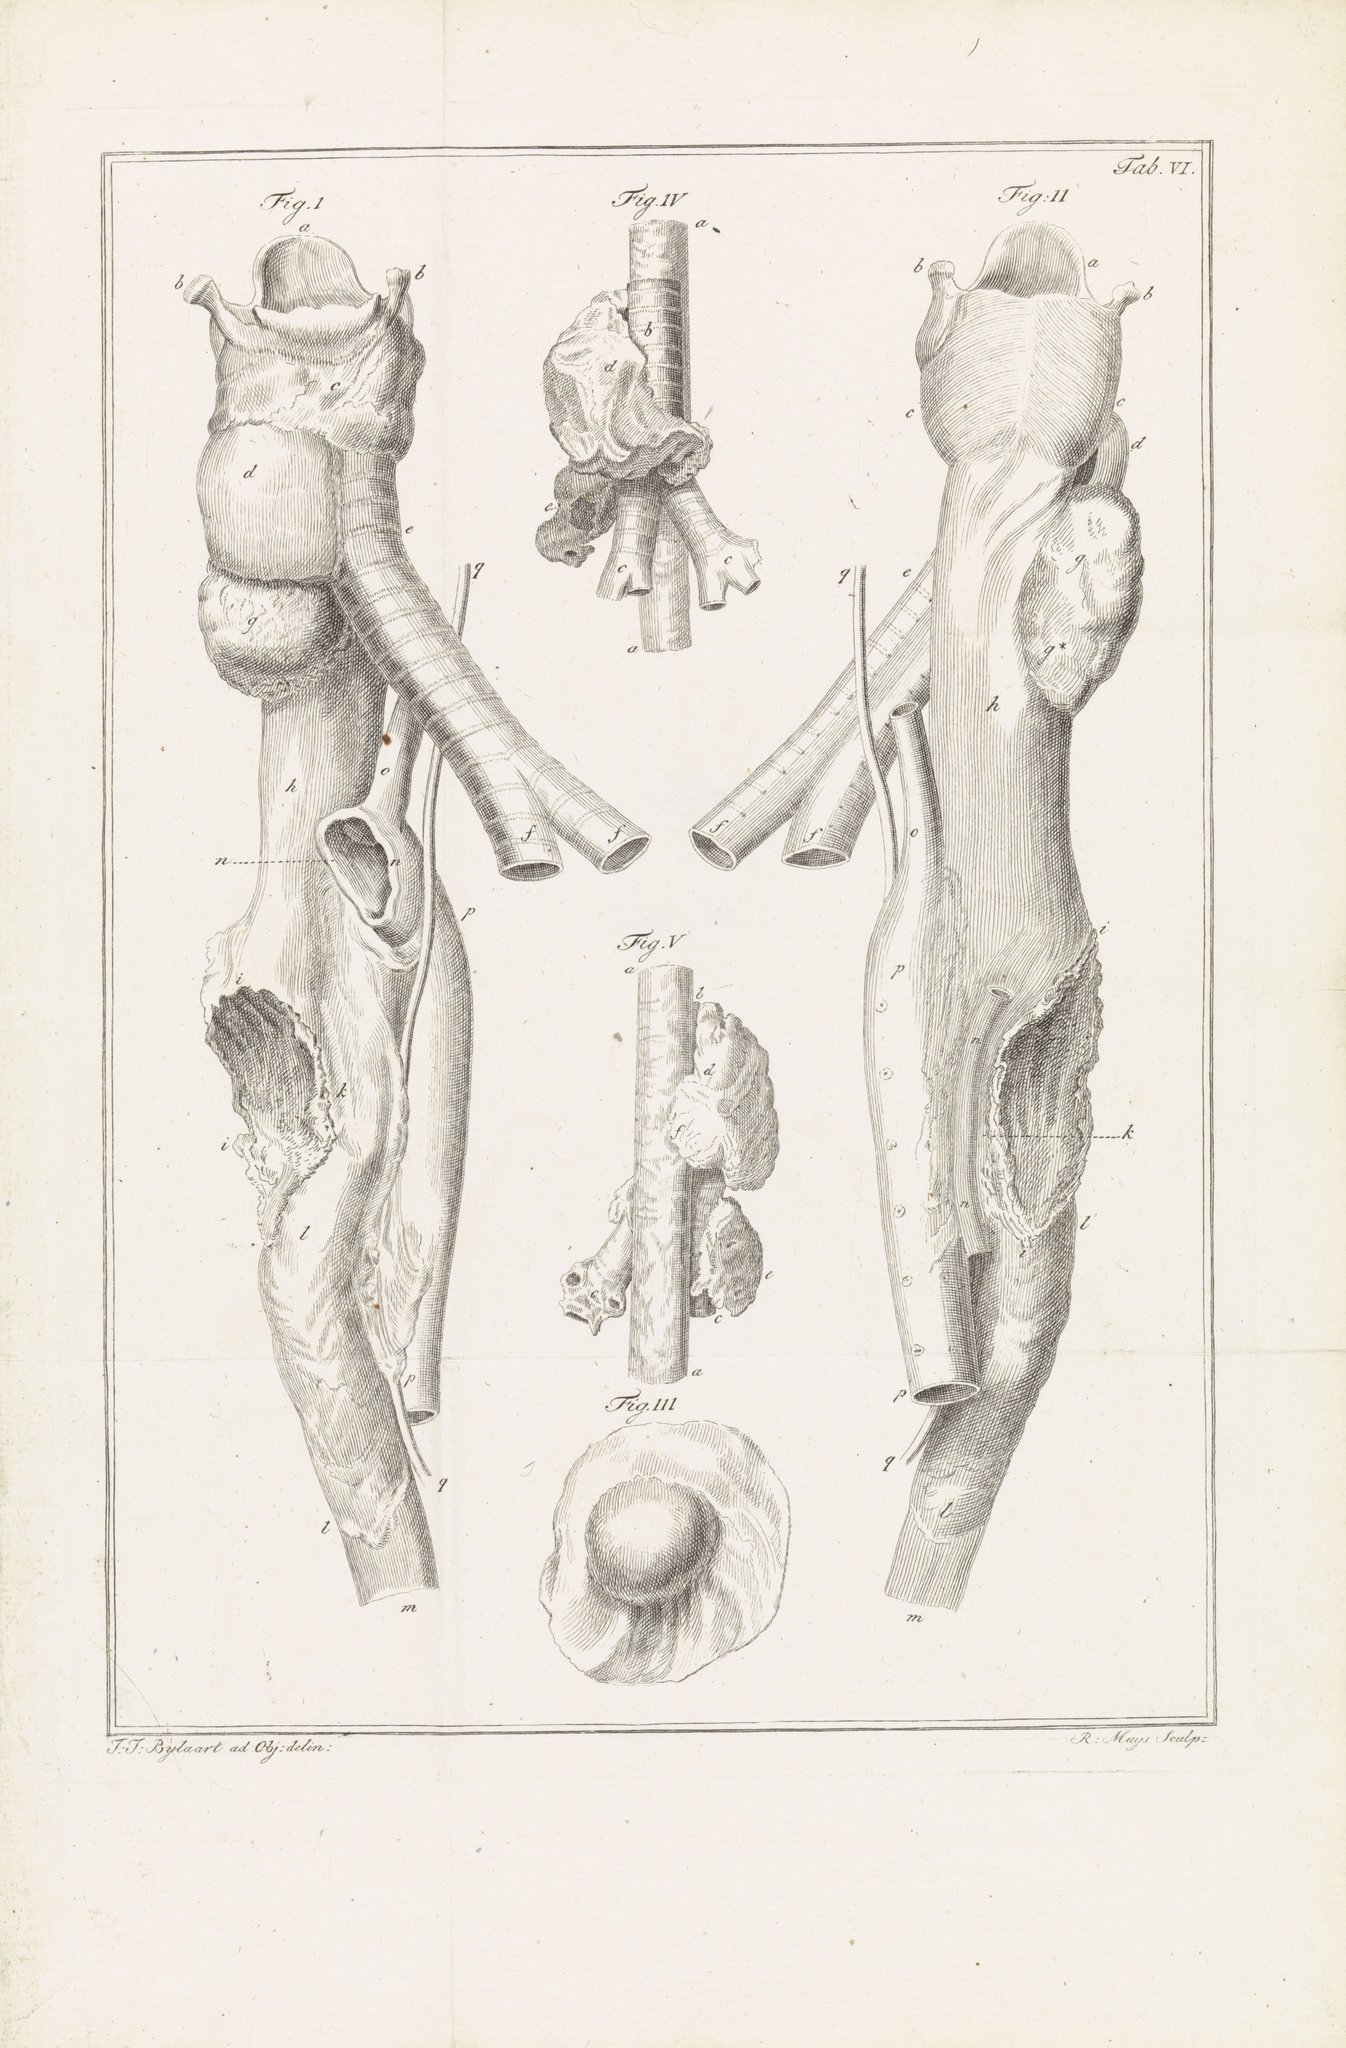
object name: print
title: Anatomische afbeelding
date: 1752-1825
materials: paper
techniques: engraving, etching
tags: physiology and anatomy (+ scientific research)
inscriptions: collector's mark: Lugt 2228, collector's mark: Lugt 2760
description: Anatomische afbeelding. Rechtsboven: Tab. VI.